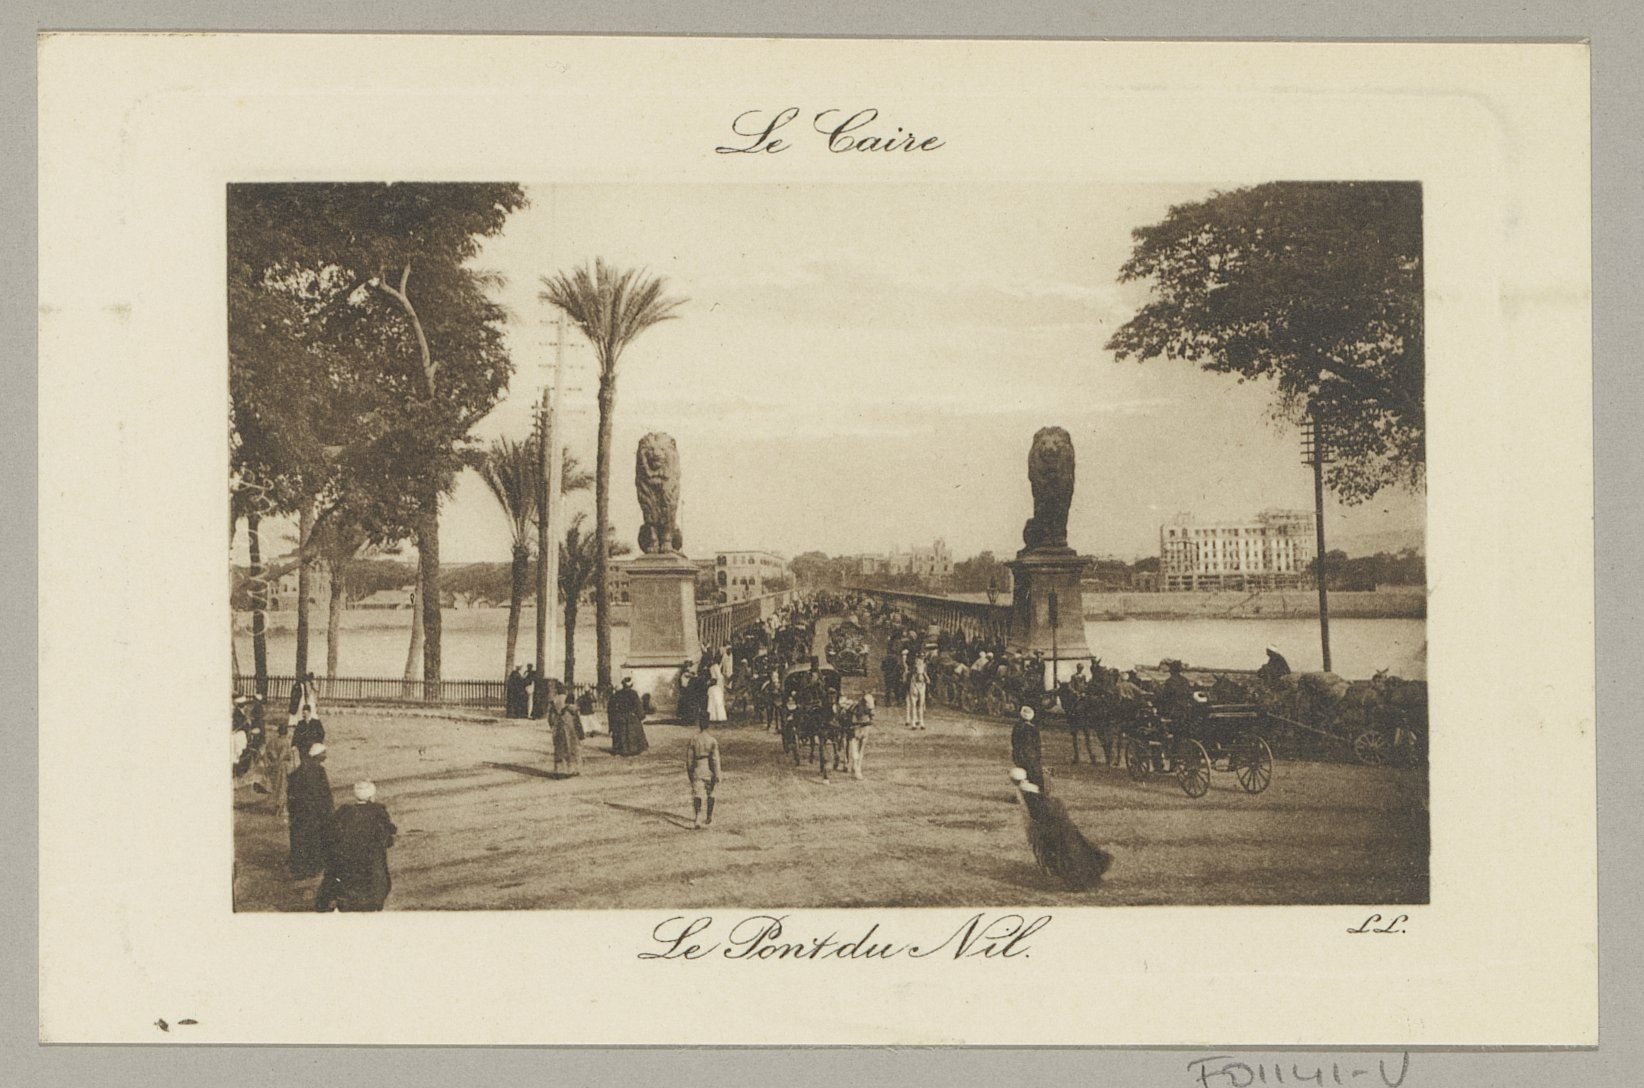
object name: photomechanical print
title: Le Caire, Le Pont du Nil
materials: paper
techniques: photograph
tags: bridge in city across river, canal, etc.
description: Onderdeel van Fotoalbum van een reis door Zuid-Europa en het Midden-Oosten.